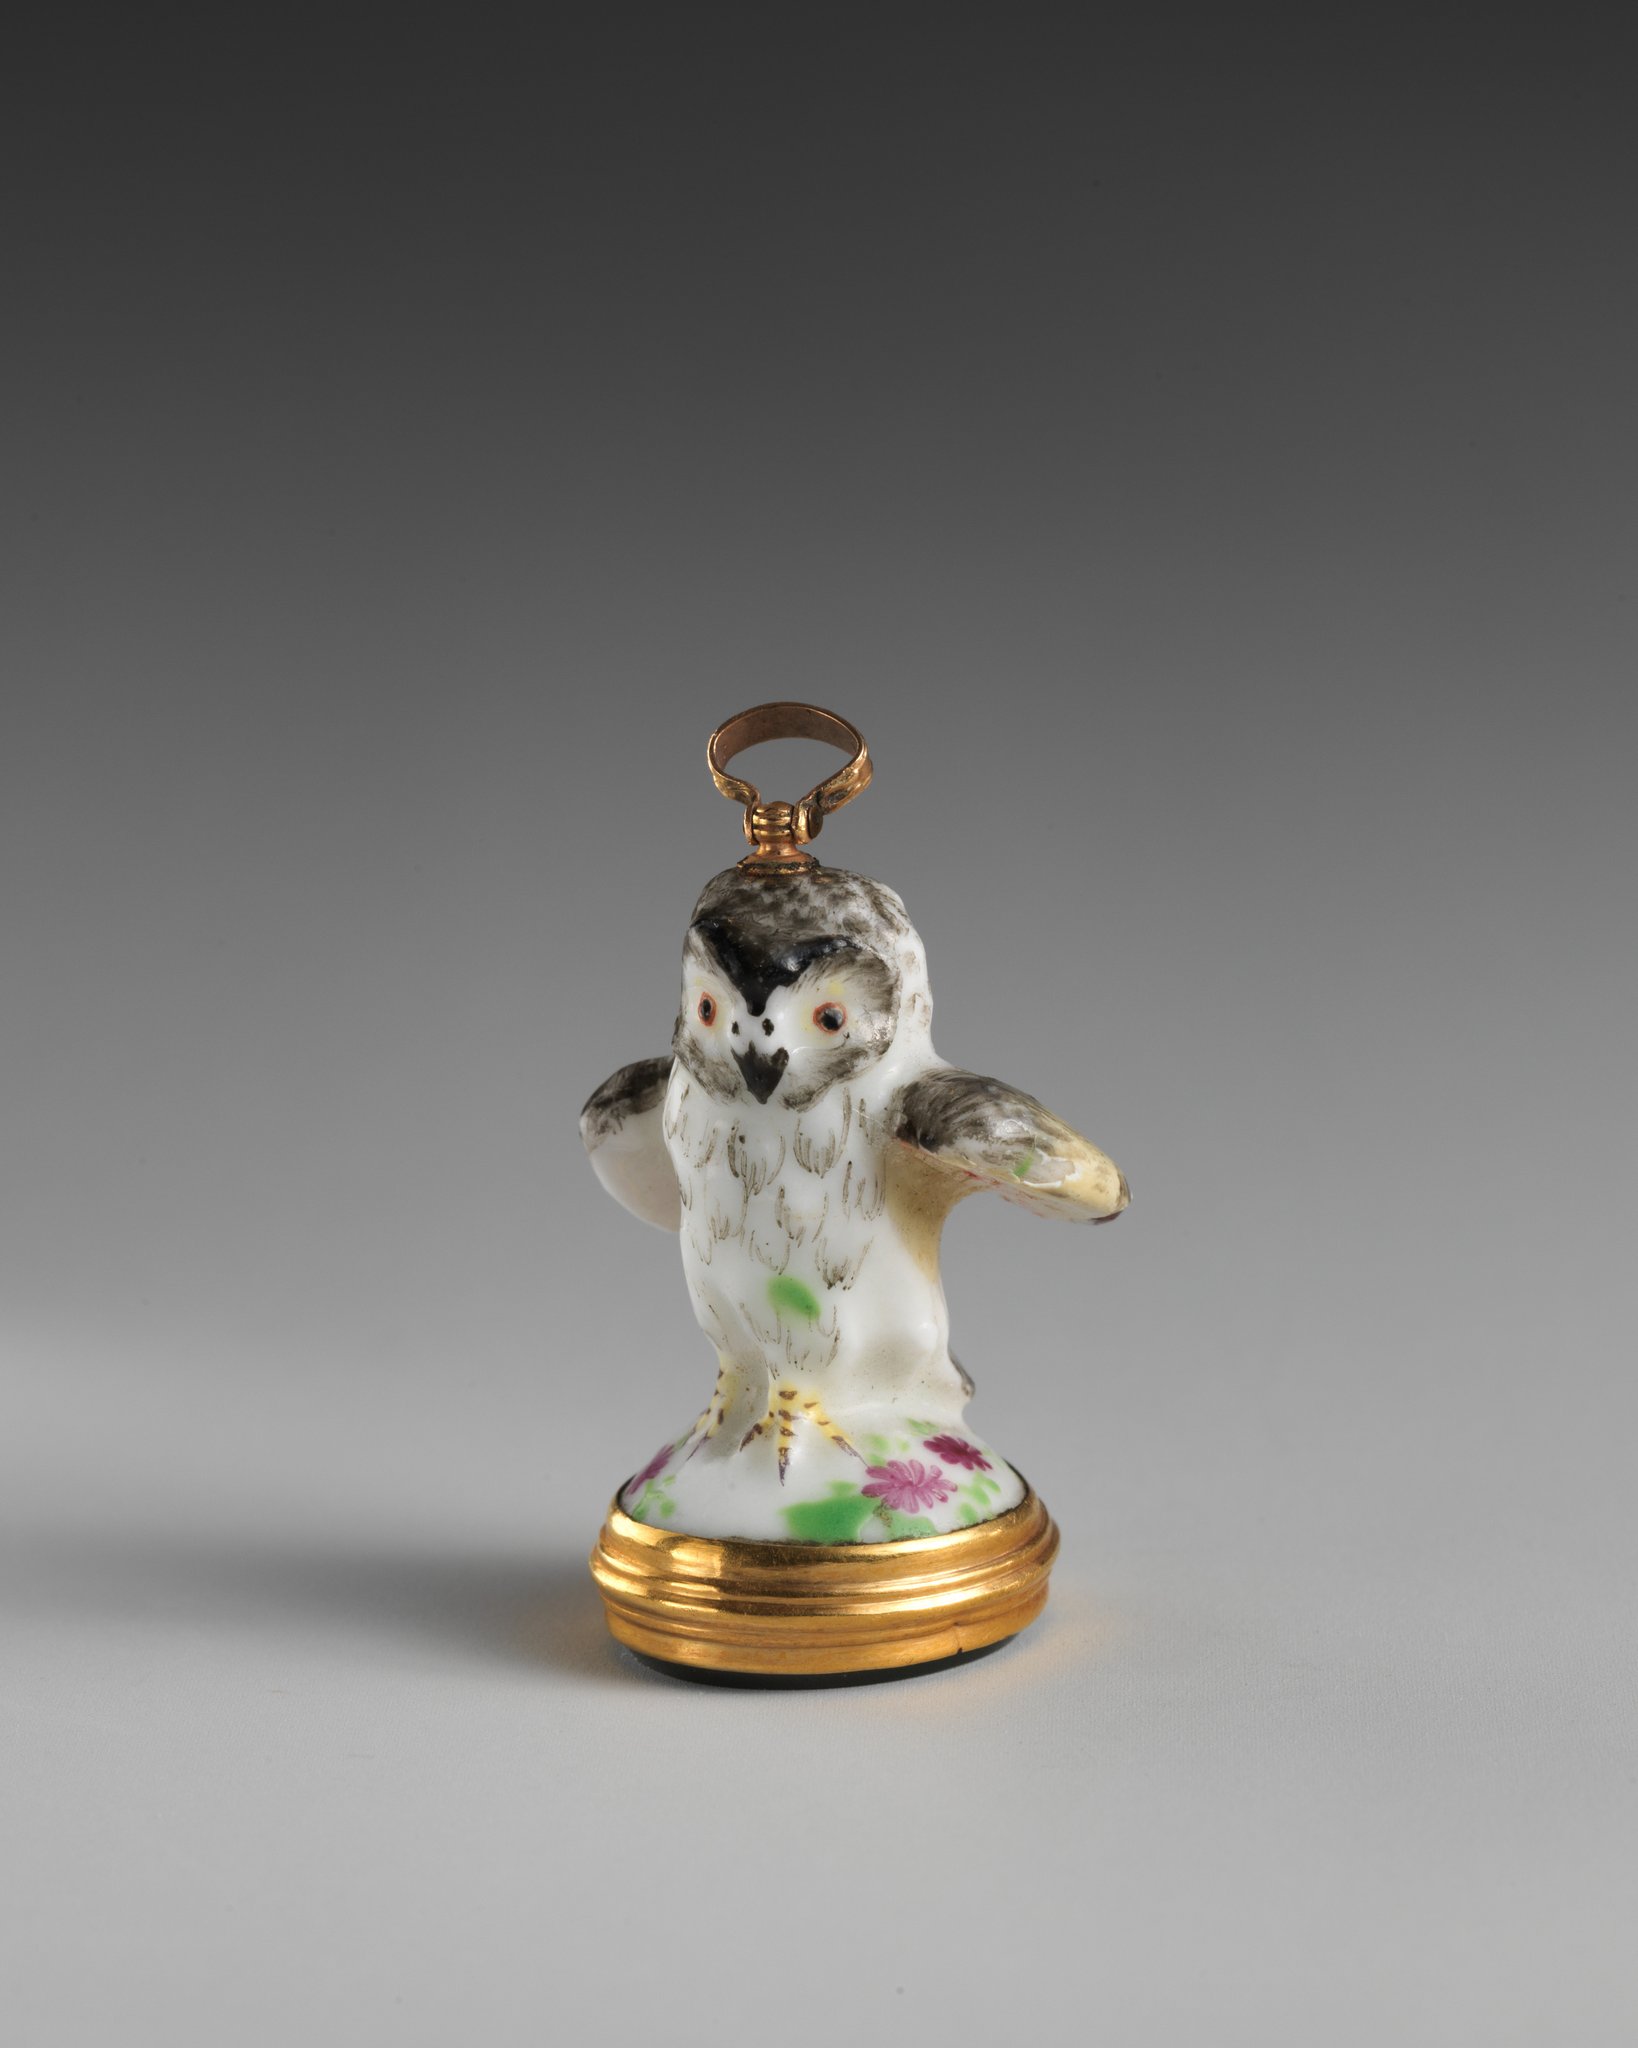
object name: seal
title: Owl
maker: chelsea porcelain manufactory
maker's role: factory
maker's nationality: british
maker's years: 1744-1784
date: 1753-1758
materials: soft paste porcelain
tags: owls